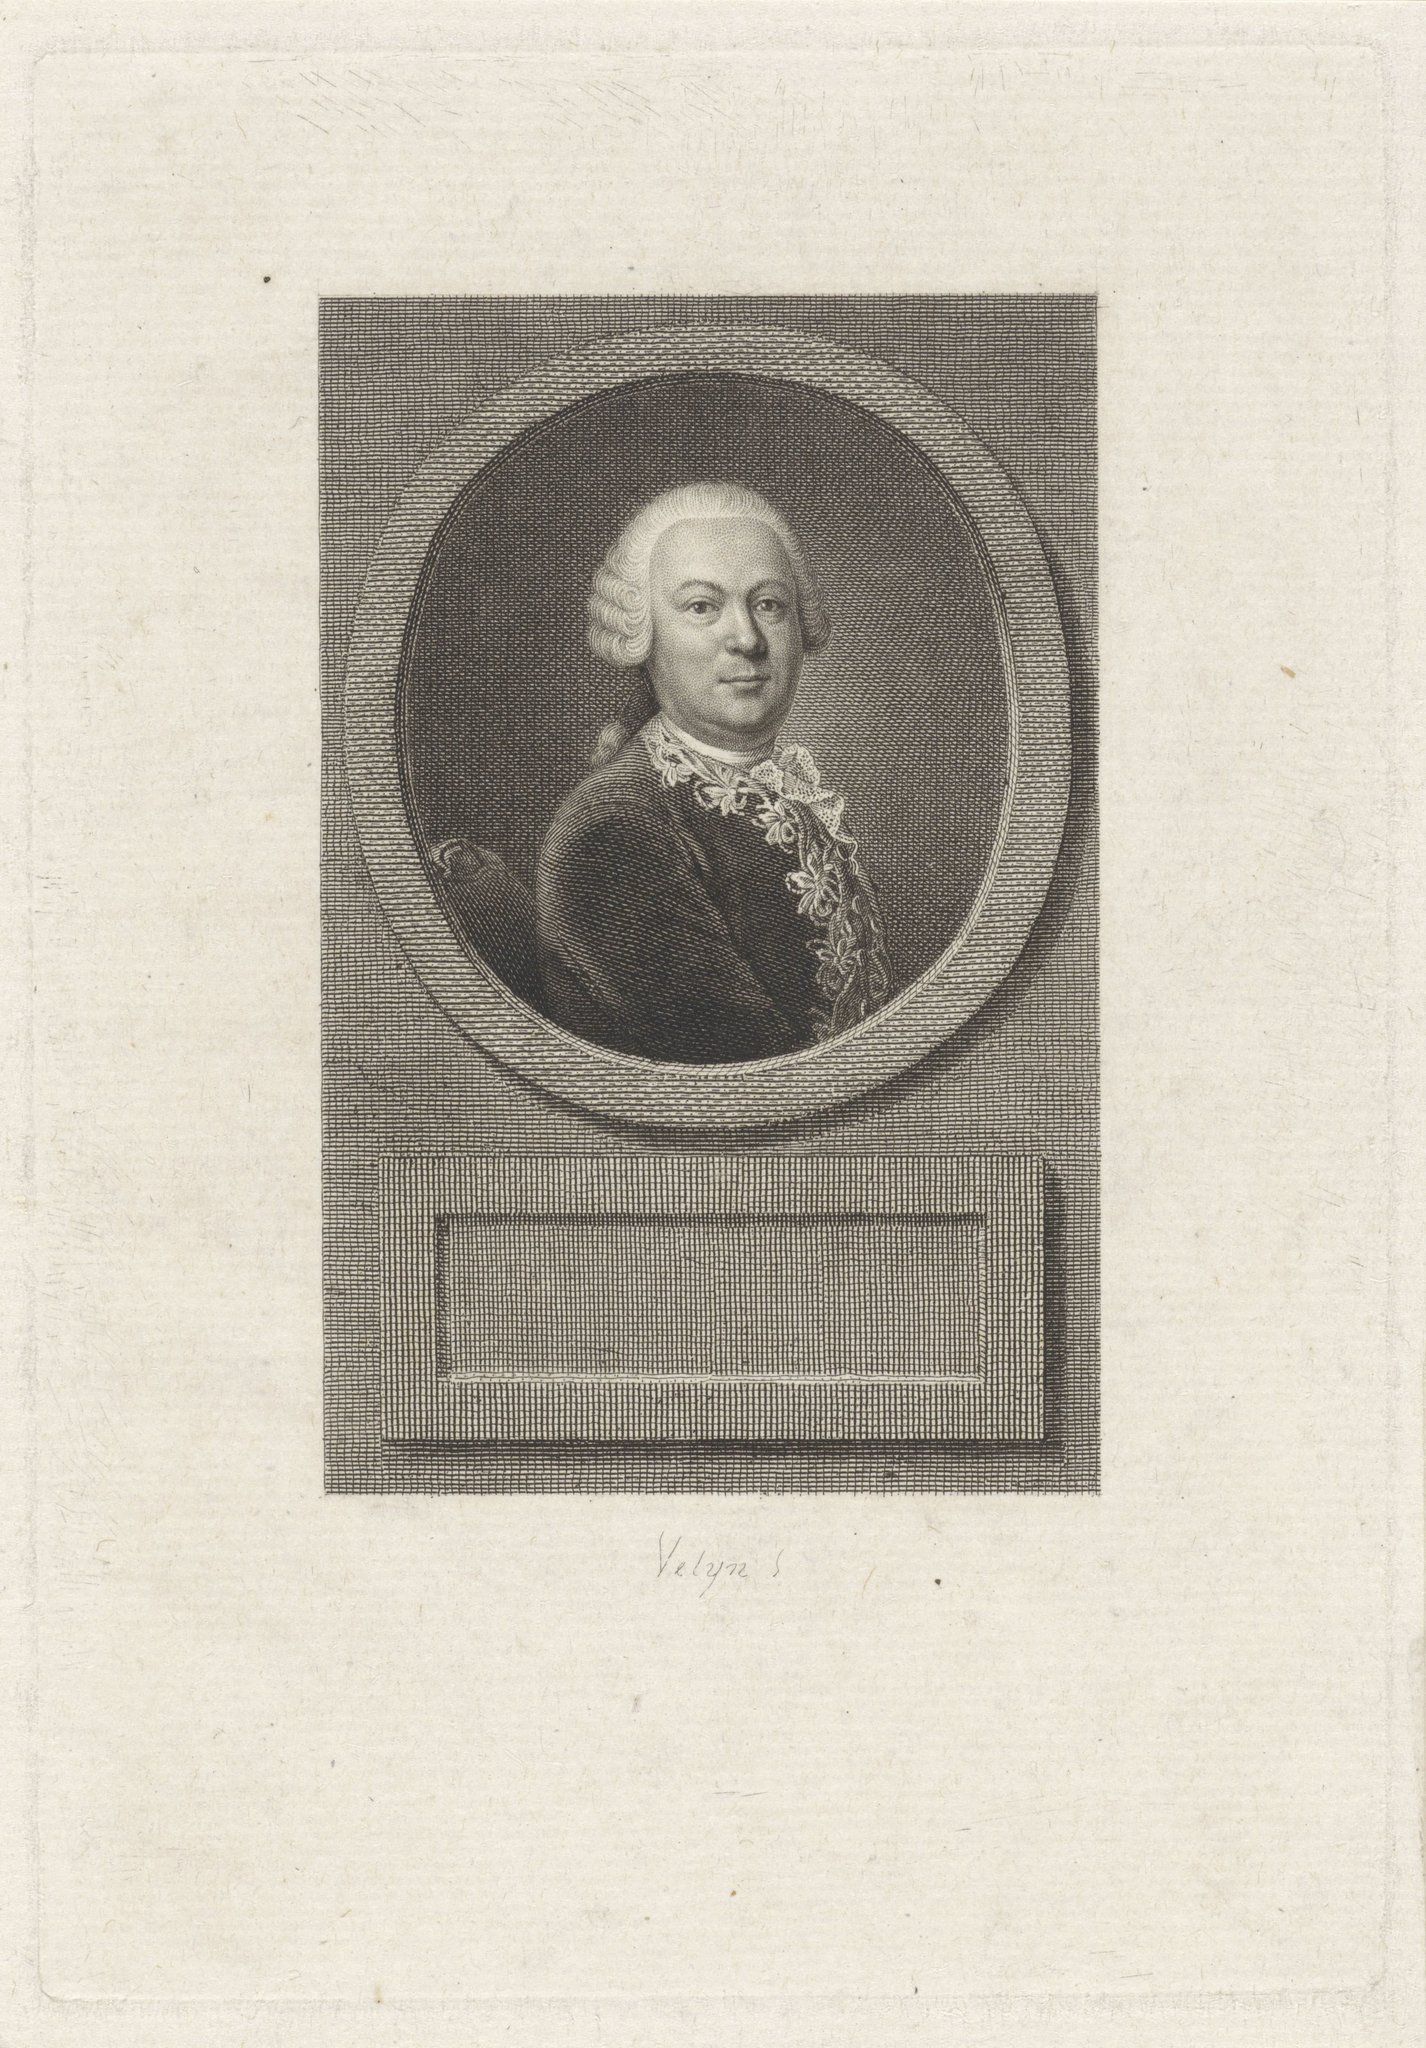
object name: print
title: Portret van Onno Zwier van Haren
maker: philippus velijn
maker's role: print maker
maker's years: 1787-1836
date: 1797-1836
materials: paper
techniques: engraving, etching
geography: netherlands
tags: onno zwier van haren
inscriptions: collector's mark: Lugt 2228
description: Portret van Onno Zwier van Haren, rechtsgeleerde en president van de Raad van State.